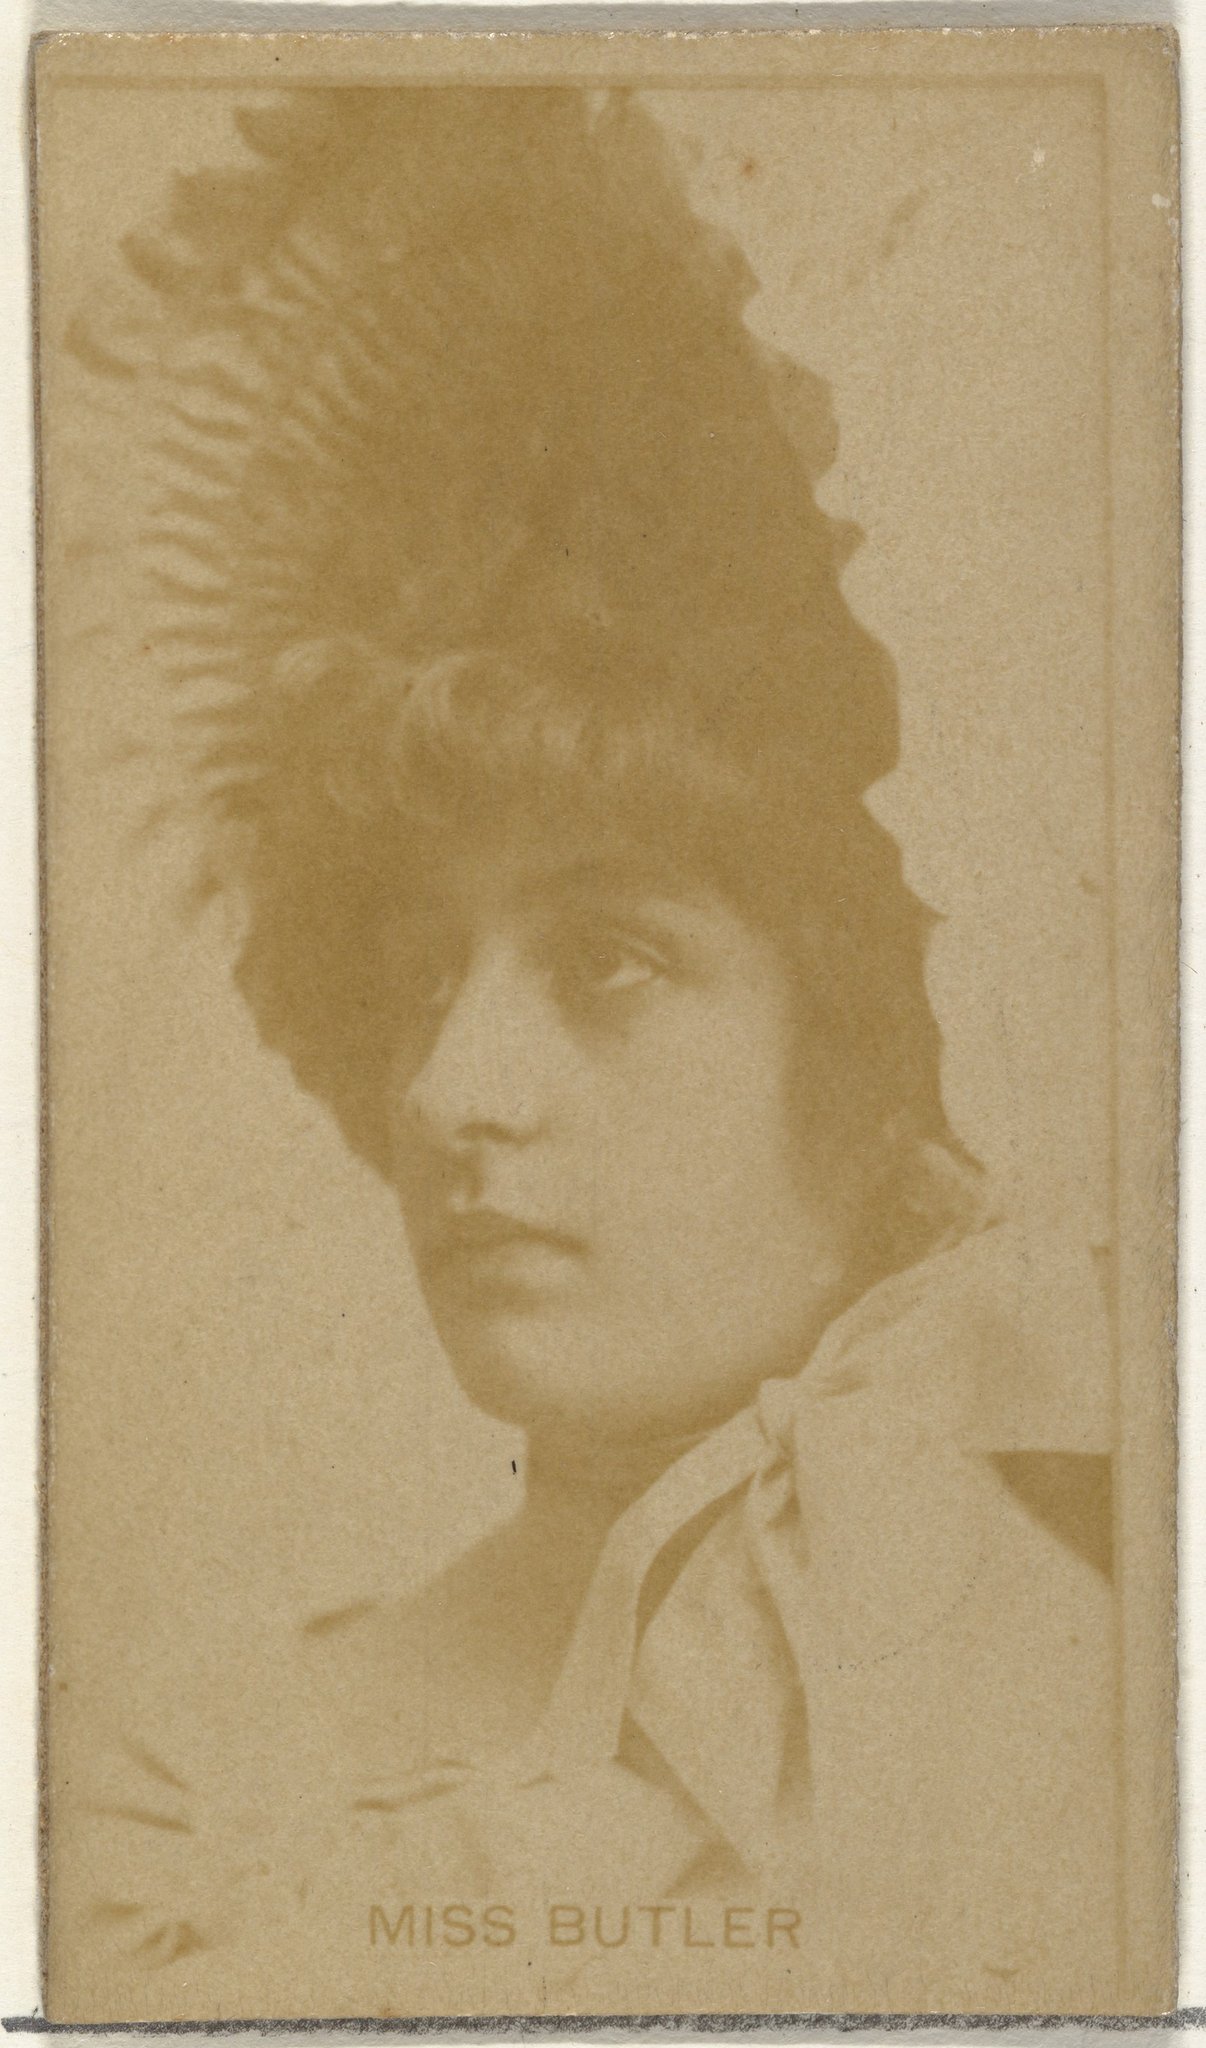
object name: photograph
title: Miss Butler, from the Actors and Actresses series (N145-8) issued by Duke Sons & Co. to promote Duke Cigarettes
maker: w. duke, sons & co.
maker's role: publisher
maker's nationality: american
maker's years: 1870-1920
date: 1891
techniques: albumen silver print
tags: portraits,women,actresses